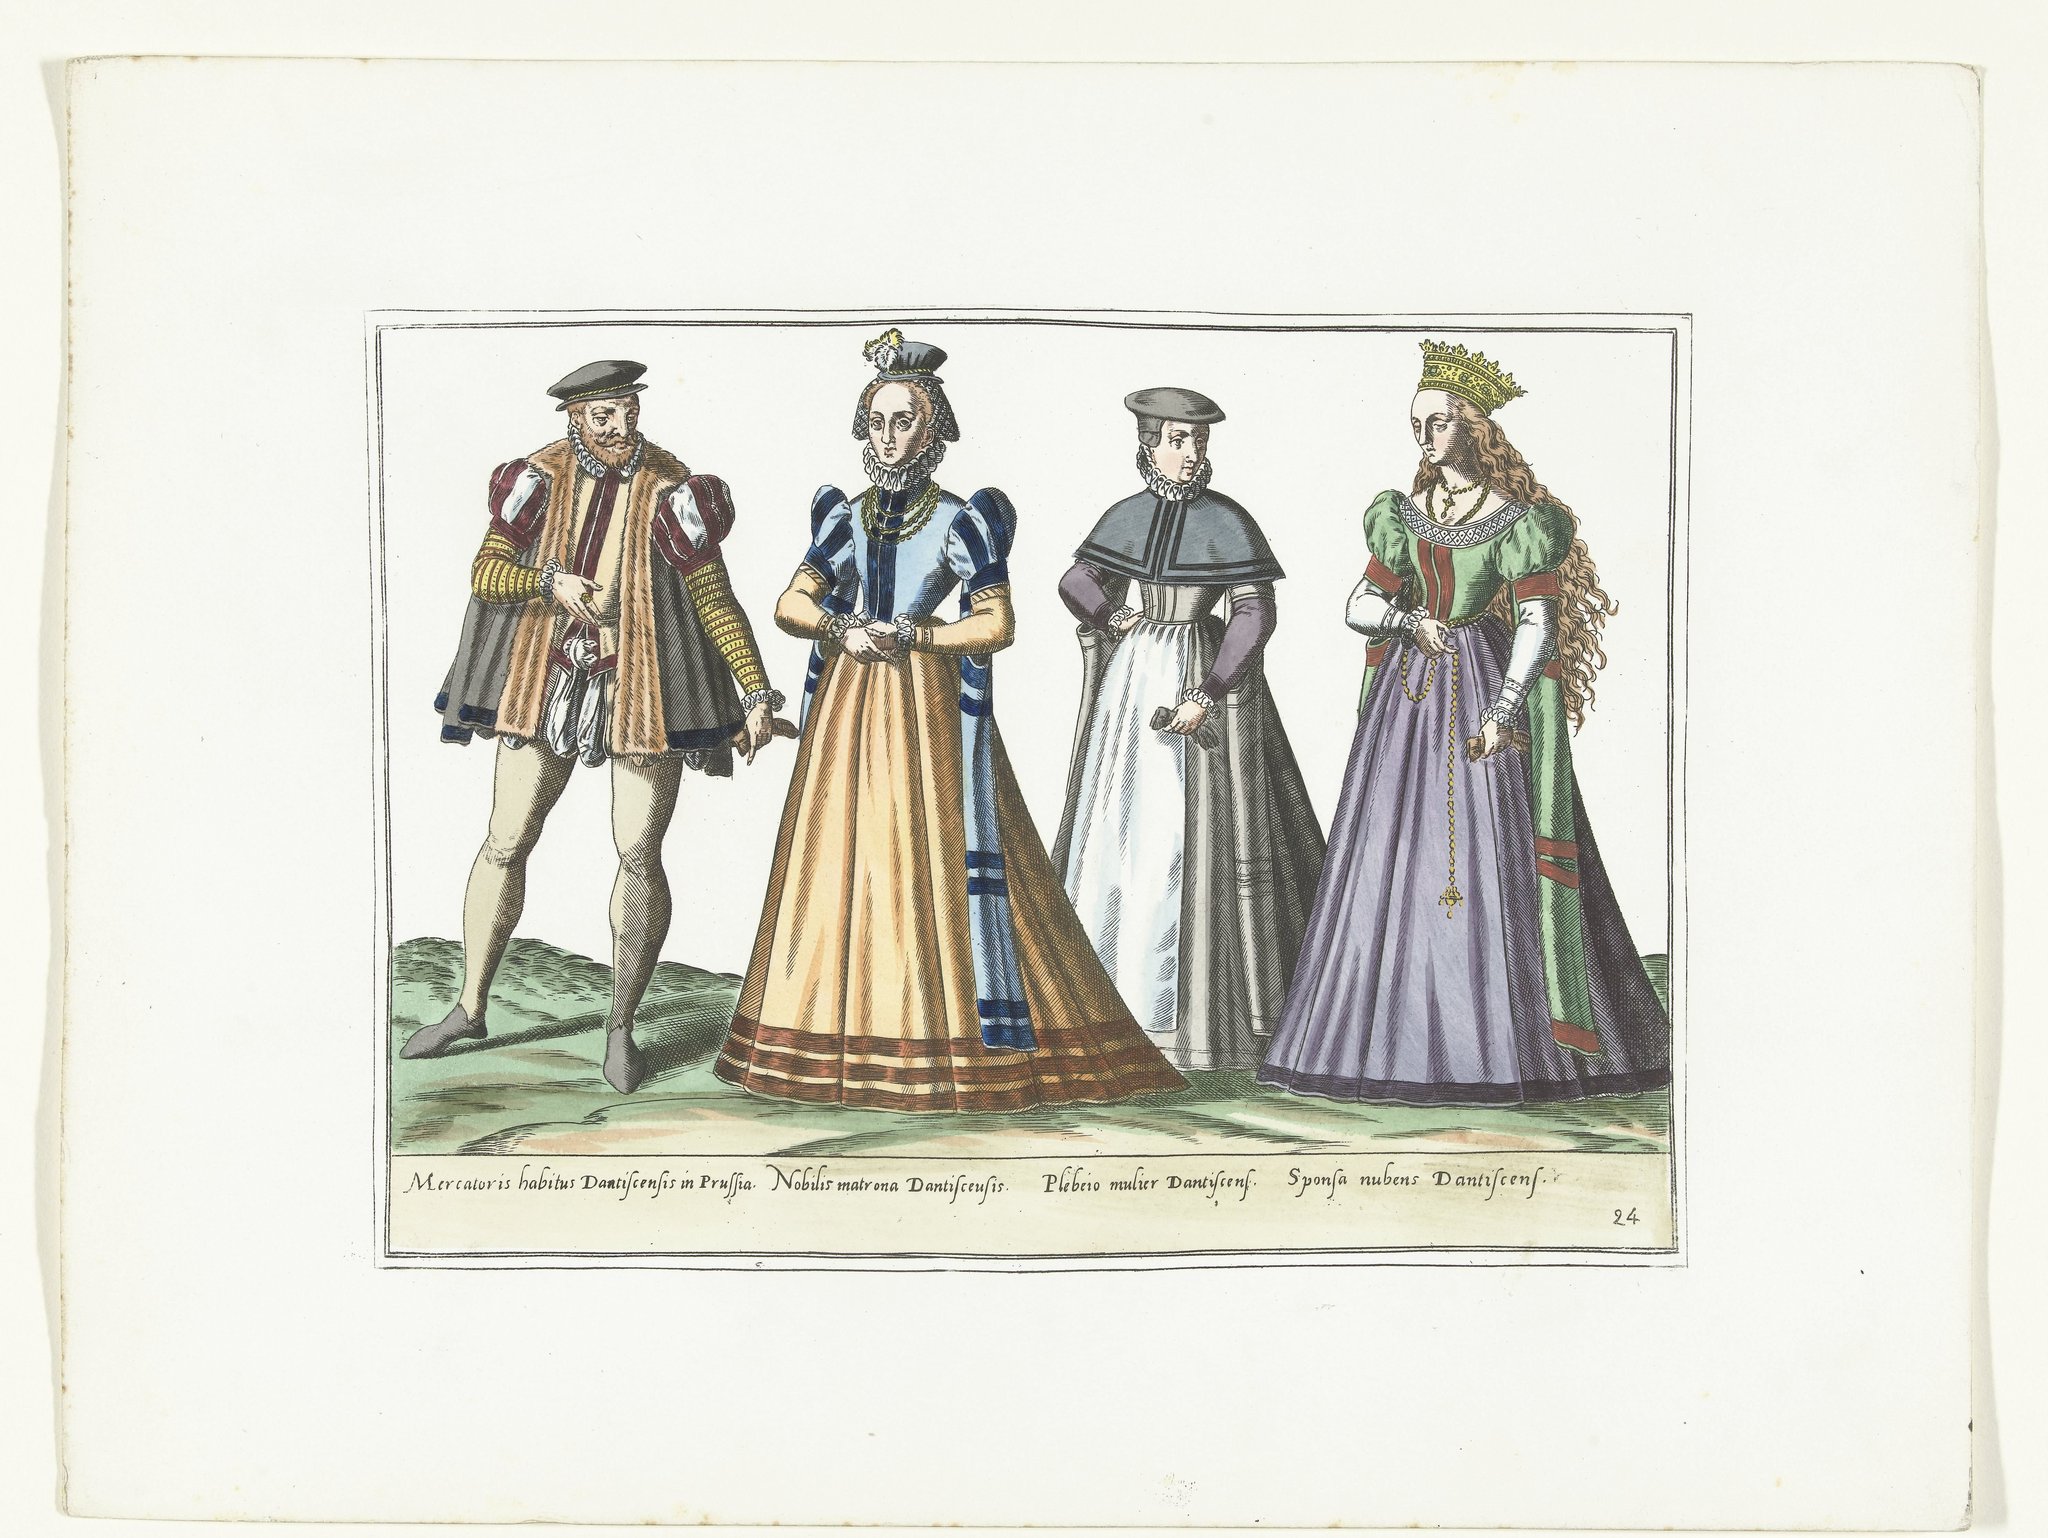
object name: print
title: Costumes Allemands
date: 1872-1875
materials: paper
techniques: hand coloring, printing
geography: brussels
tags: clothes, costume (+ men's clothes)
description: Onderdeel van Costumes civils et militaires du XVIe siècle par A. de Bruyn, een selectie van prenten uit de Trachtenbuch van Abraham de Bruyn uit 1581 (Hollstein 248-306), in facsimile. Losbladig uitgegeven met titelbladen, verklaring en lijst van de platen door G.A. van Trigt te Brussel in 1875 met teksten van Auguste Schoy. In de Rijksmuseum Research Library met signatuur 34 C 43.